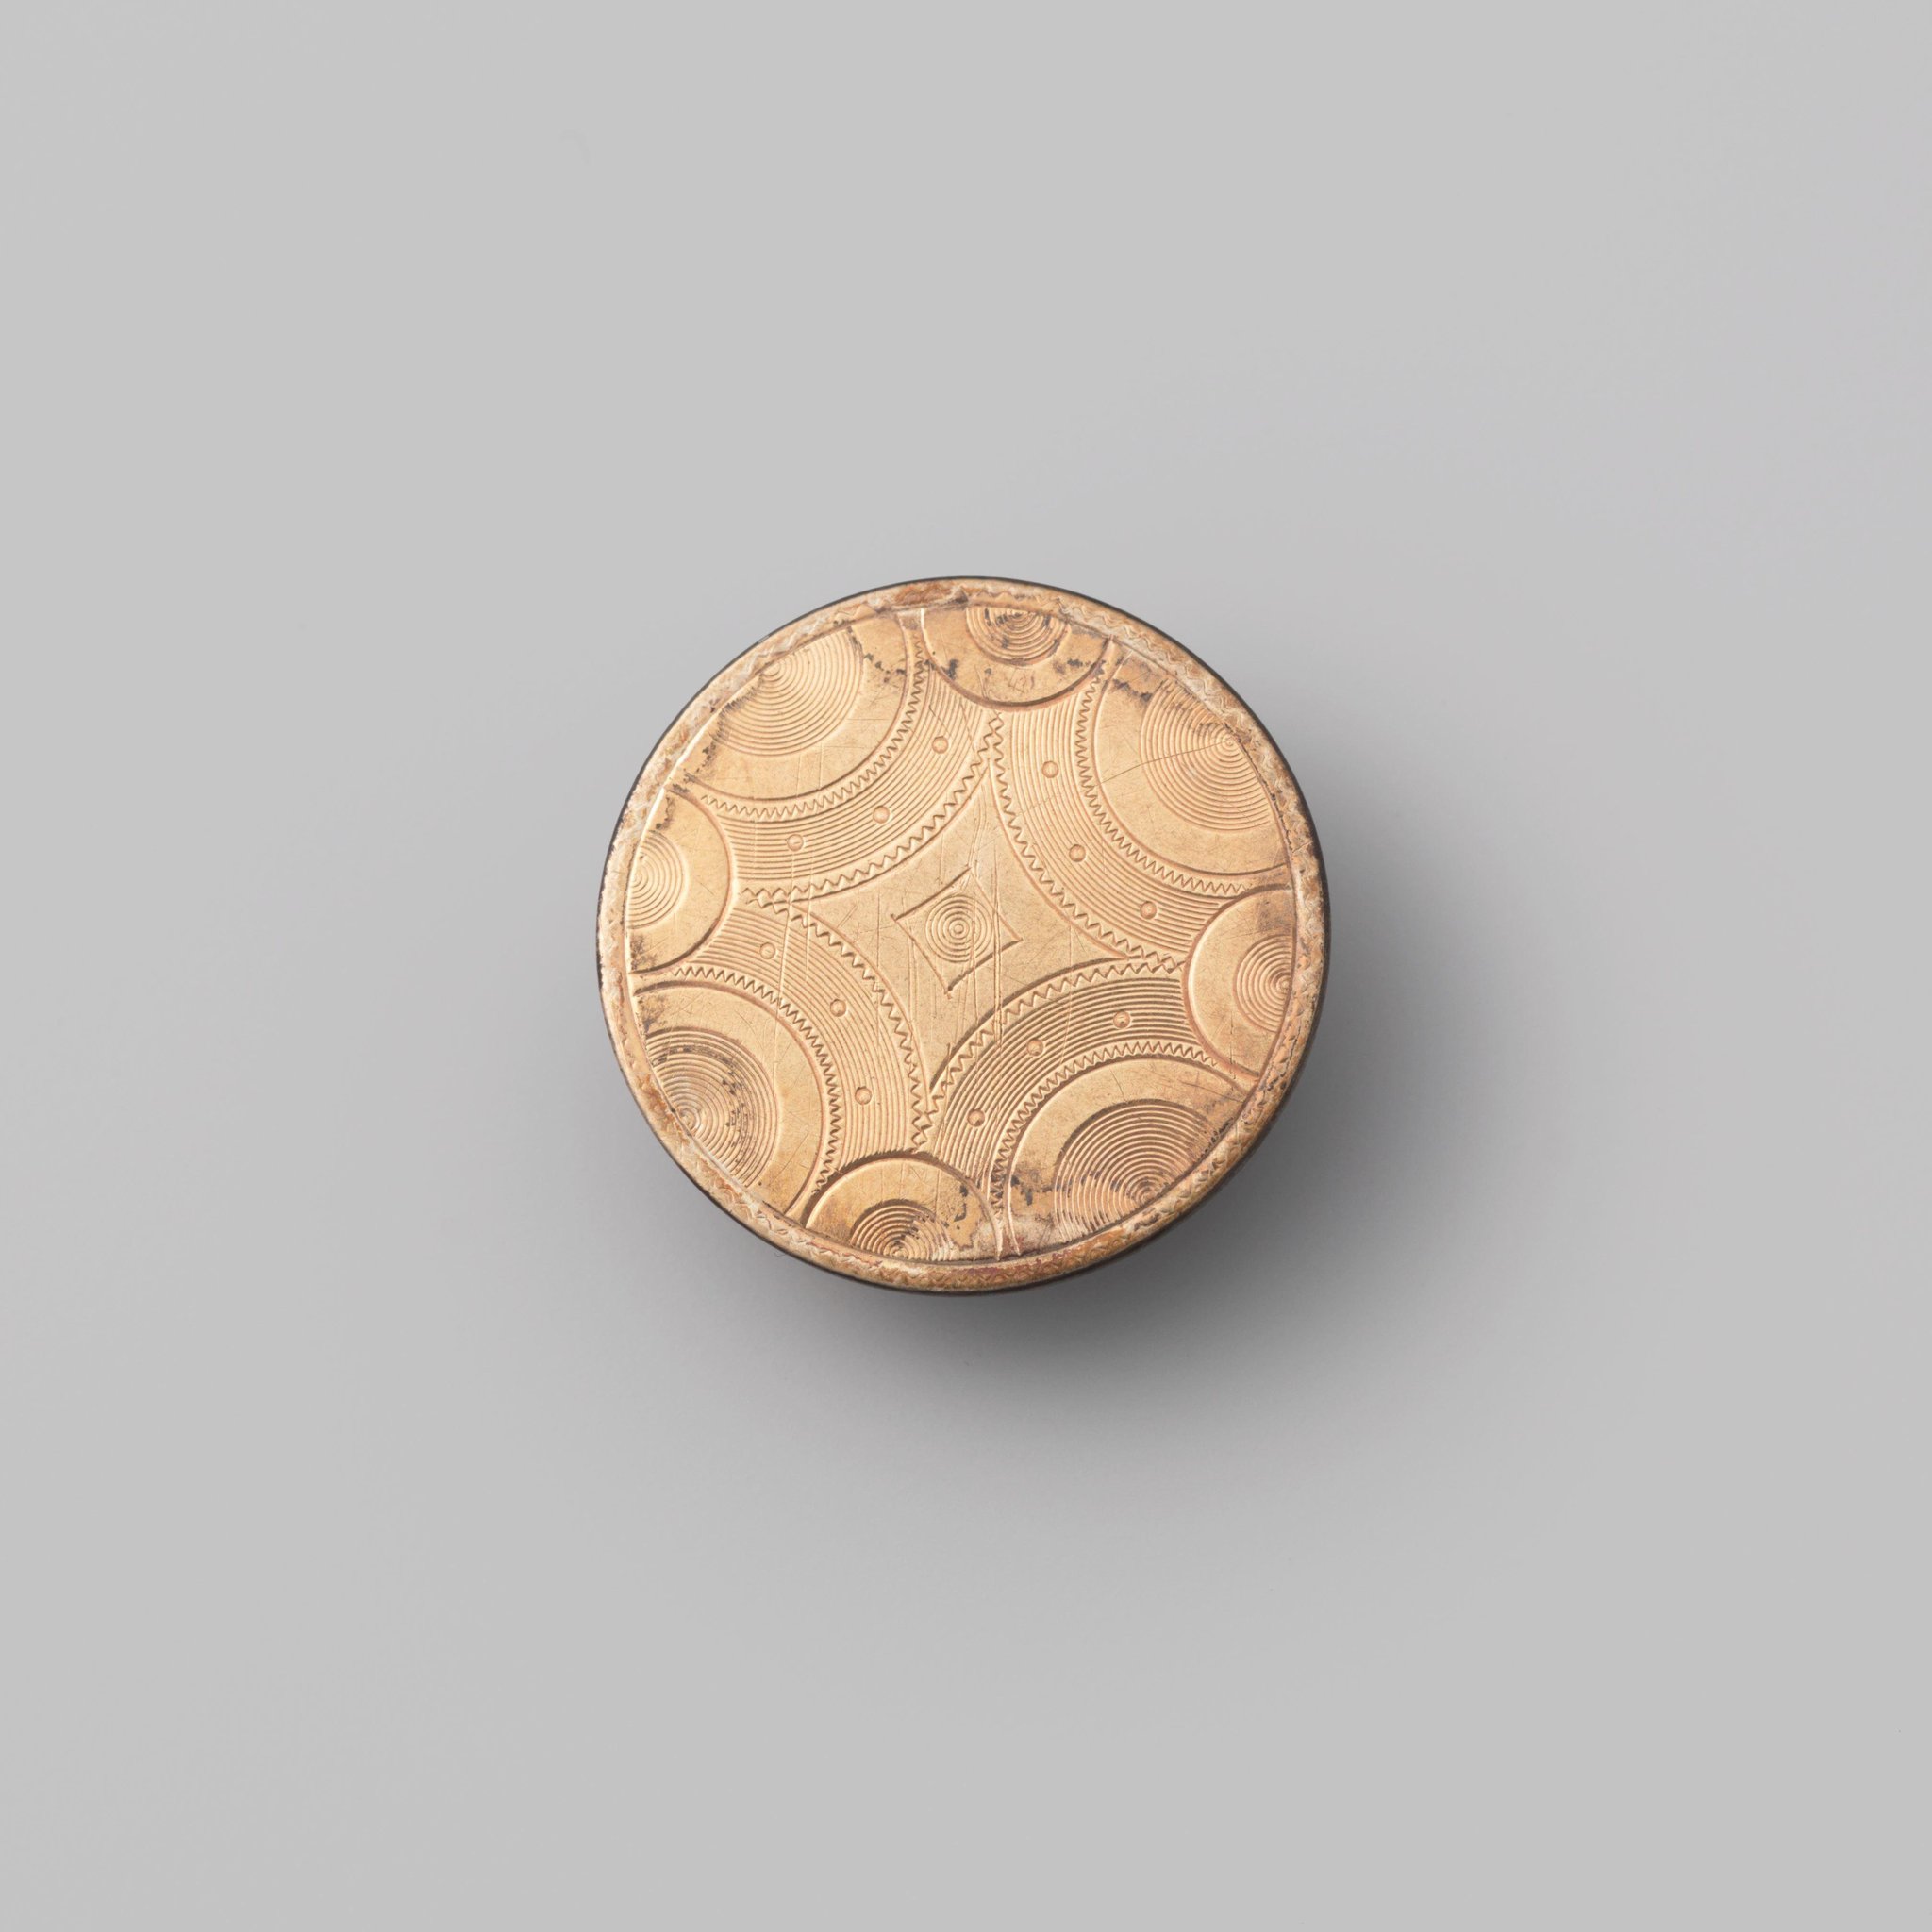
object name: cuff link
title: Platte ronde manchetknoop van verguld zilver, versierd met guilloches met een ruitje met holle zijden en acht concentrische gladde cirkelbogen daaromheen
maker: Anonymous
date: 1850-1899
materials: silver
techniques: engraving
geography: netherlands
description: Platte ronde manchetknoop van verguld zilver, versierd met guilloches met een ruitje met holle zijden en acht concentrische gladde cirkelbogen daaromheen. Onleesbare merkjes; doorgeslagen.